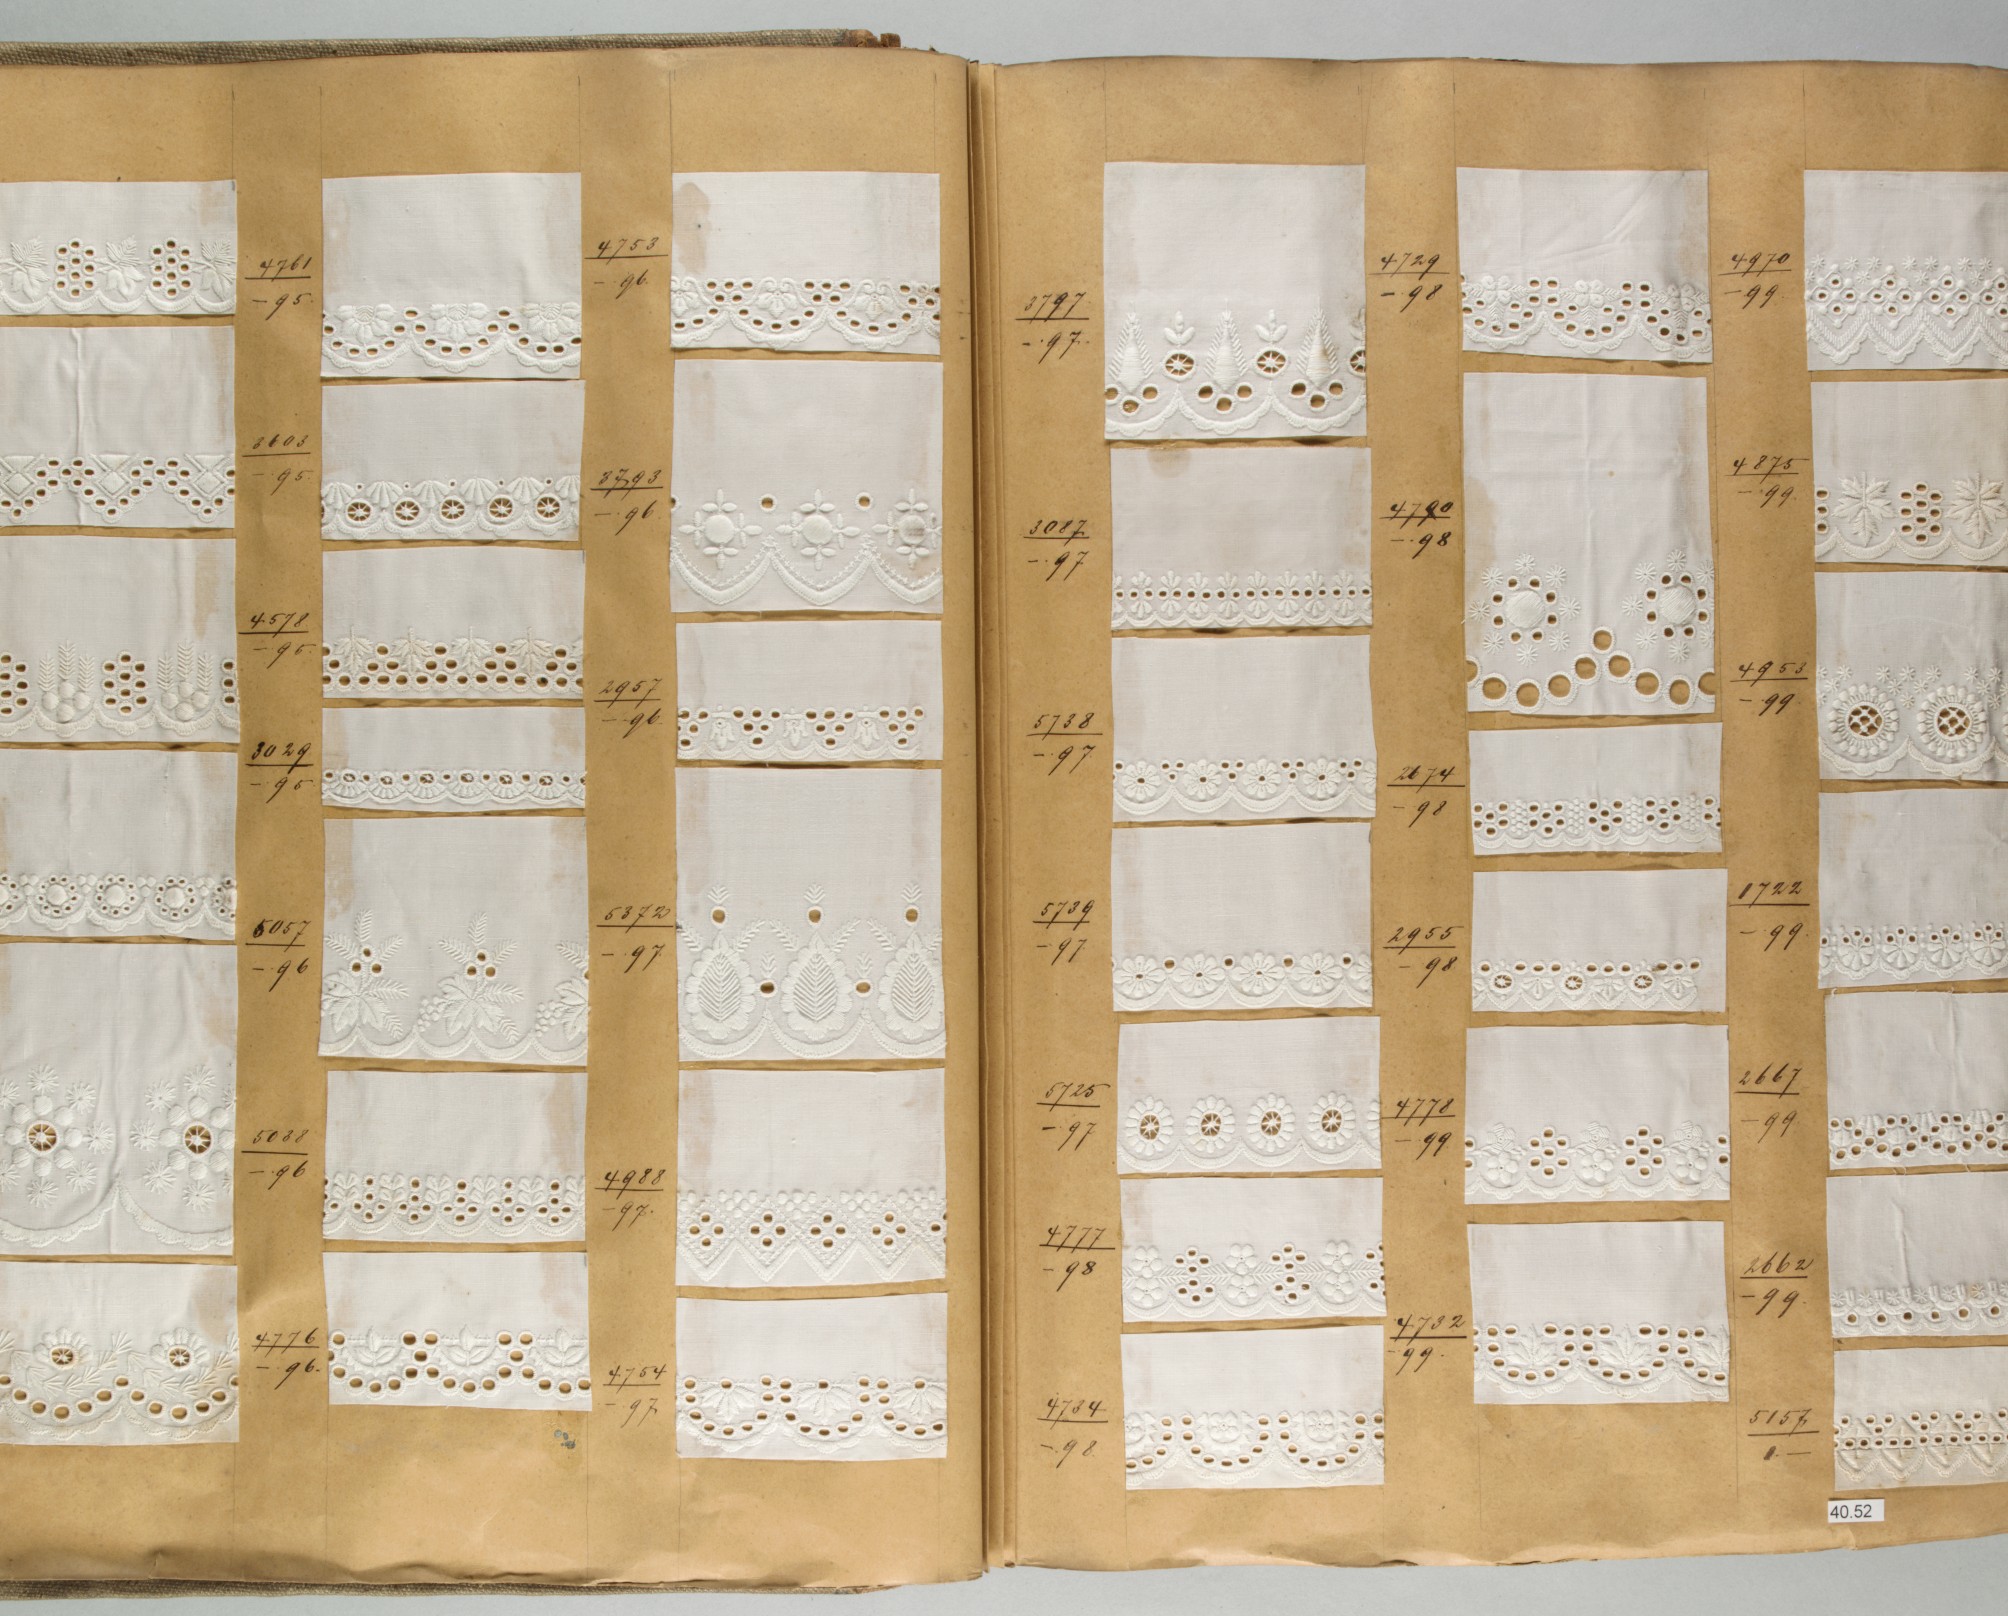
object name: sample book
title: Textile Sample Book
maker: ullman frères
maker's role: maker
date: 1870-1878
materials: cotton